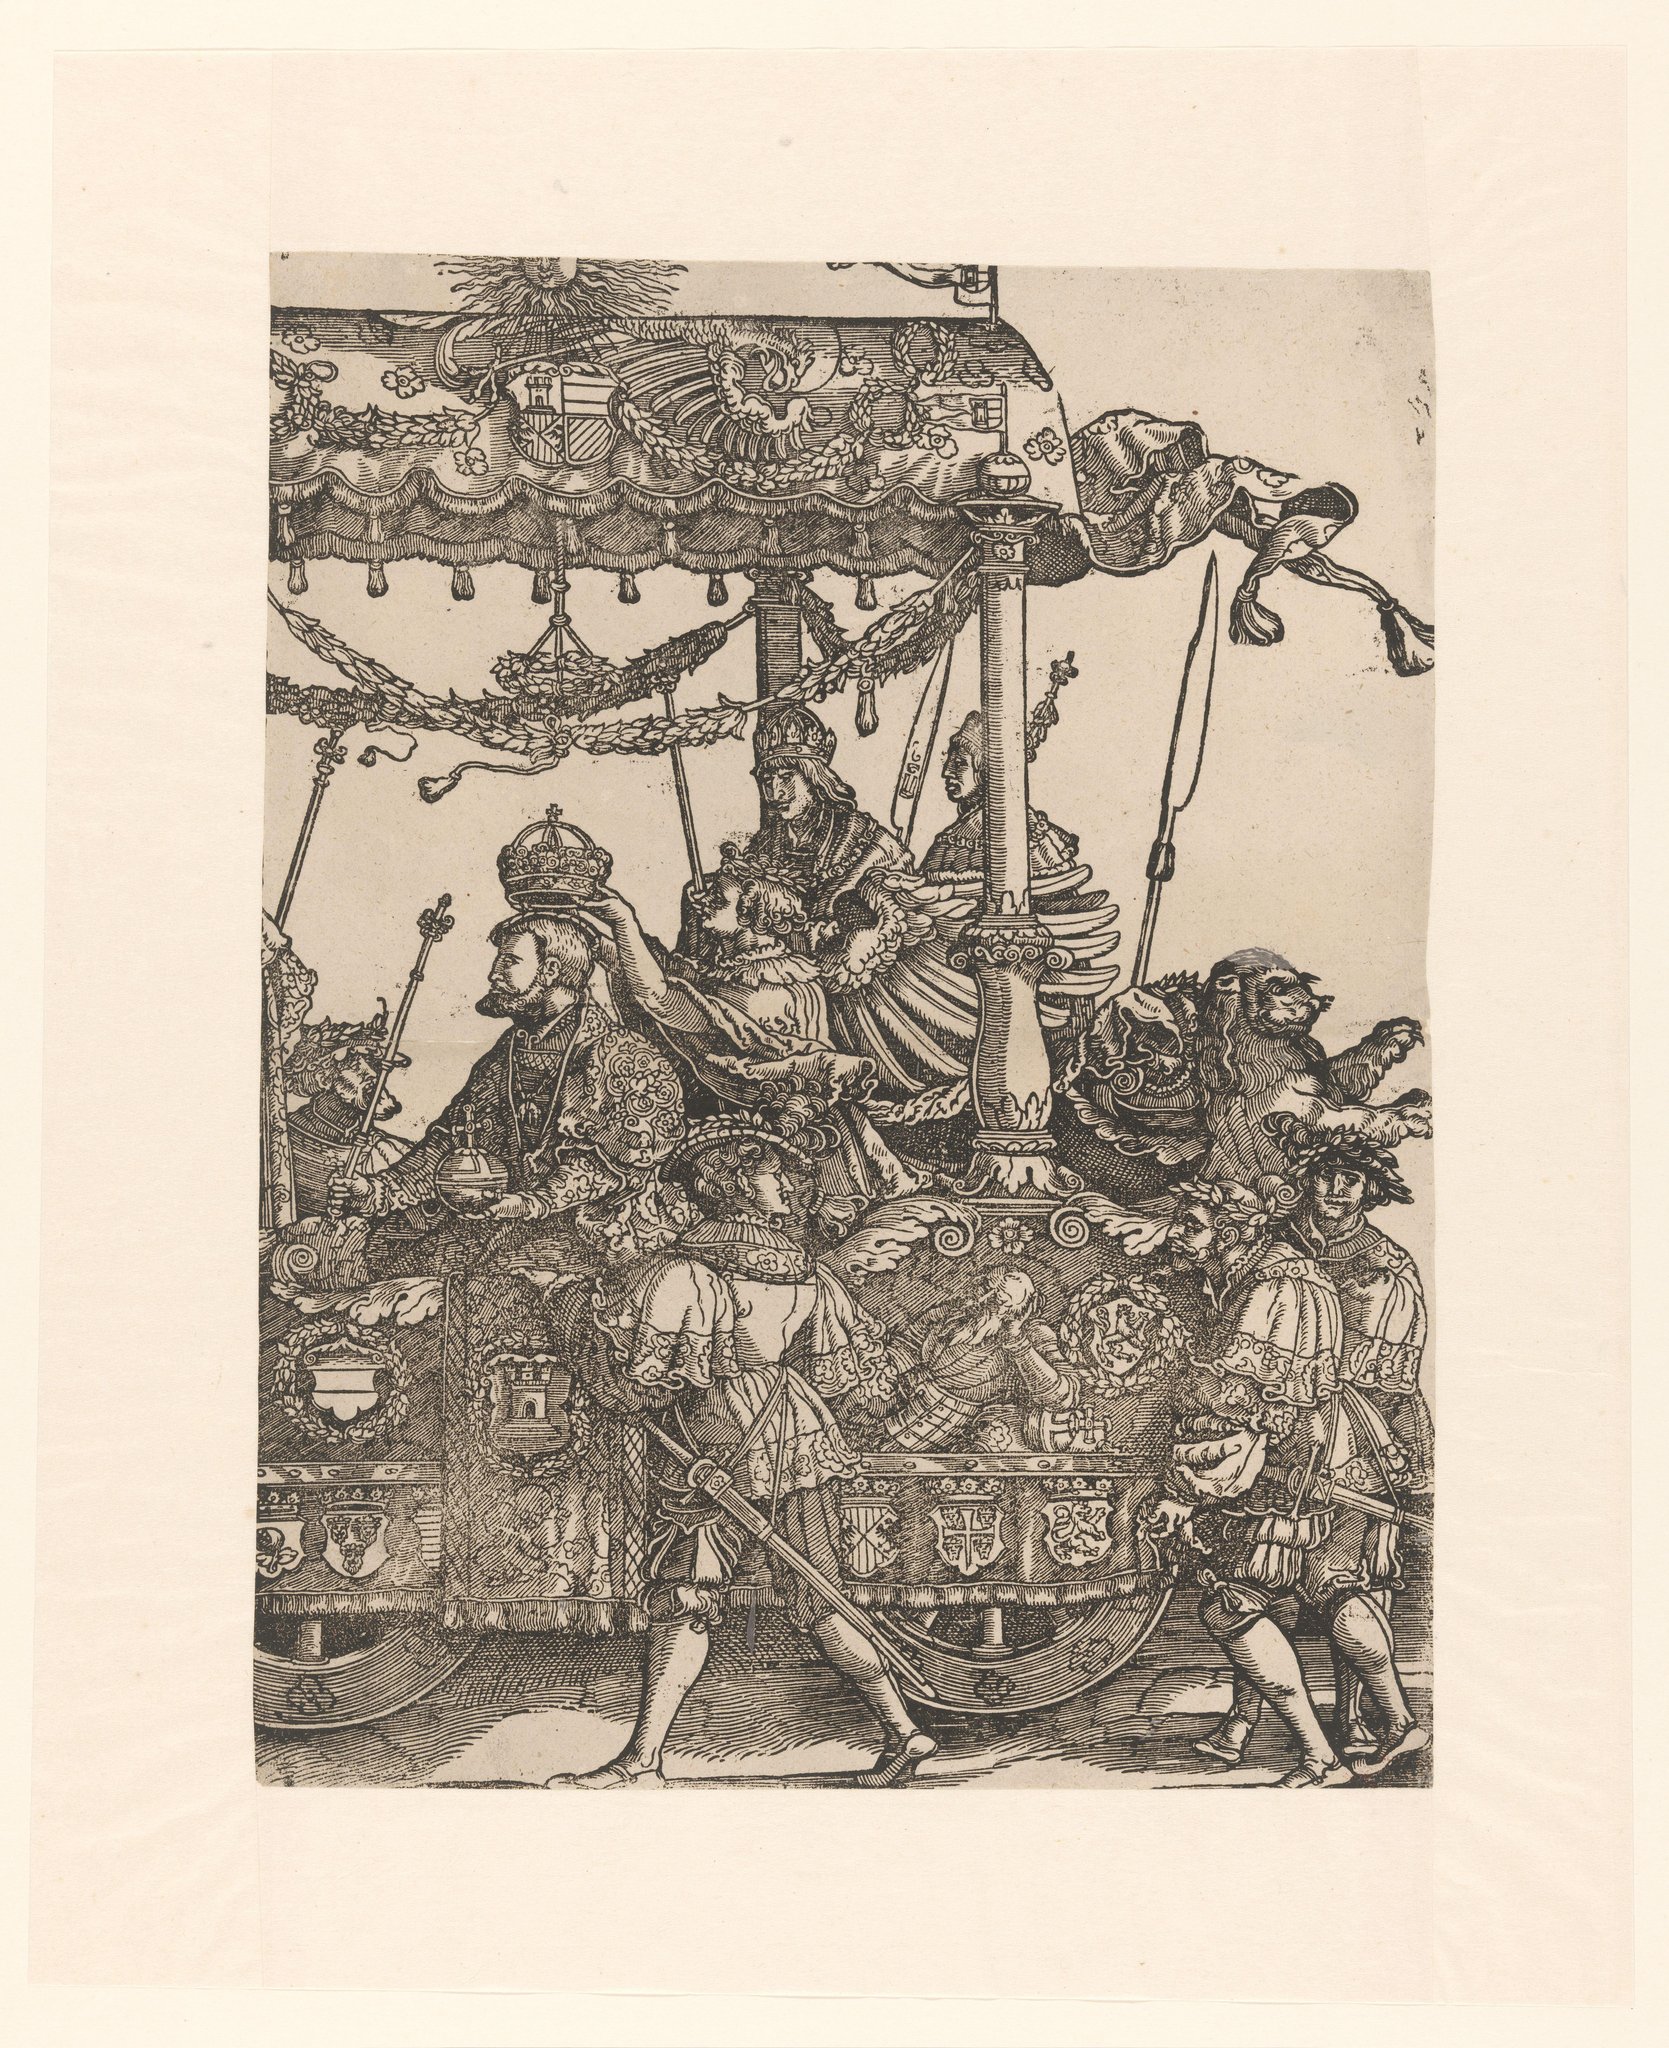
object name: print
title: Triomfwagen met keizer Karel V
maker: hans schäufelein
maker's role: print maker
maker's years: 1480-1540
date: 1537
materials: paper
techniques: woodcut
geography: germany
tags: ghent, charles v (holy roman emperor and king of spain), chariot, triumphal car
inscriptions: collector's mark: Lugt 2166, collector's mark: Lugt 2228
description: Serie van 9 houtsneden van de triomfwagen van keizer Karel V die aan elkaar tot een doorlopend fries gemonteerd kunnen worden. De teksten boven de voorstellingen ontbreken in deze druk. Uitgave van deze tweede staat van de blokken is volgens German Hollstein (dl. XLII, p. 126) te dateren ca. 1537-1551. De watermerken van deze afdrukken wijzen op een latere datering ca. 1580-1616. De prenten worden hier beschreven naar de volgorde in Bartsch, een andere volgende dan in Hollstein en Geisberg staat, namelijk met de platen Hollstein German 51 en 52 (de plaat met het impressum) niet als de derde en vierde platen maar als achtste en negende (voorlaatste en laatste).